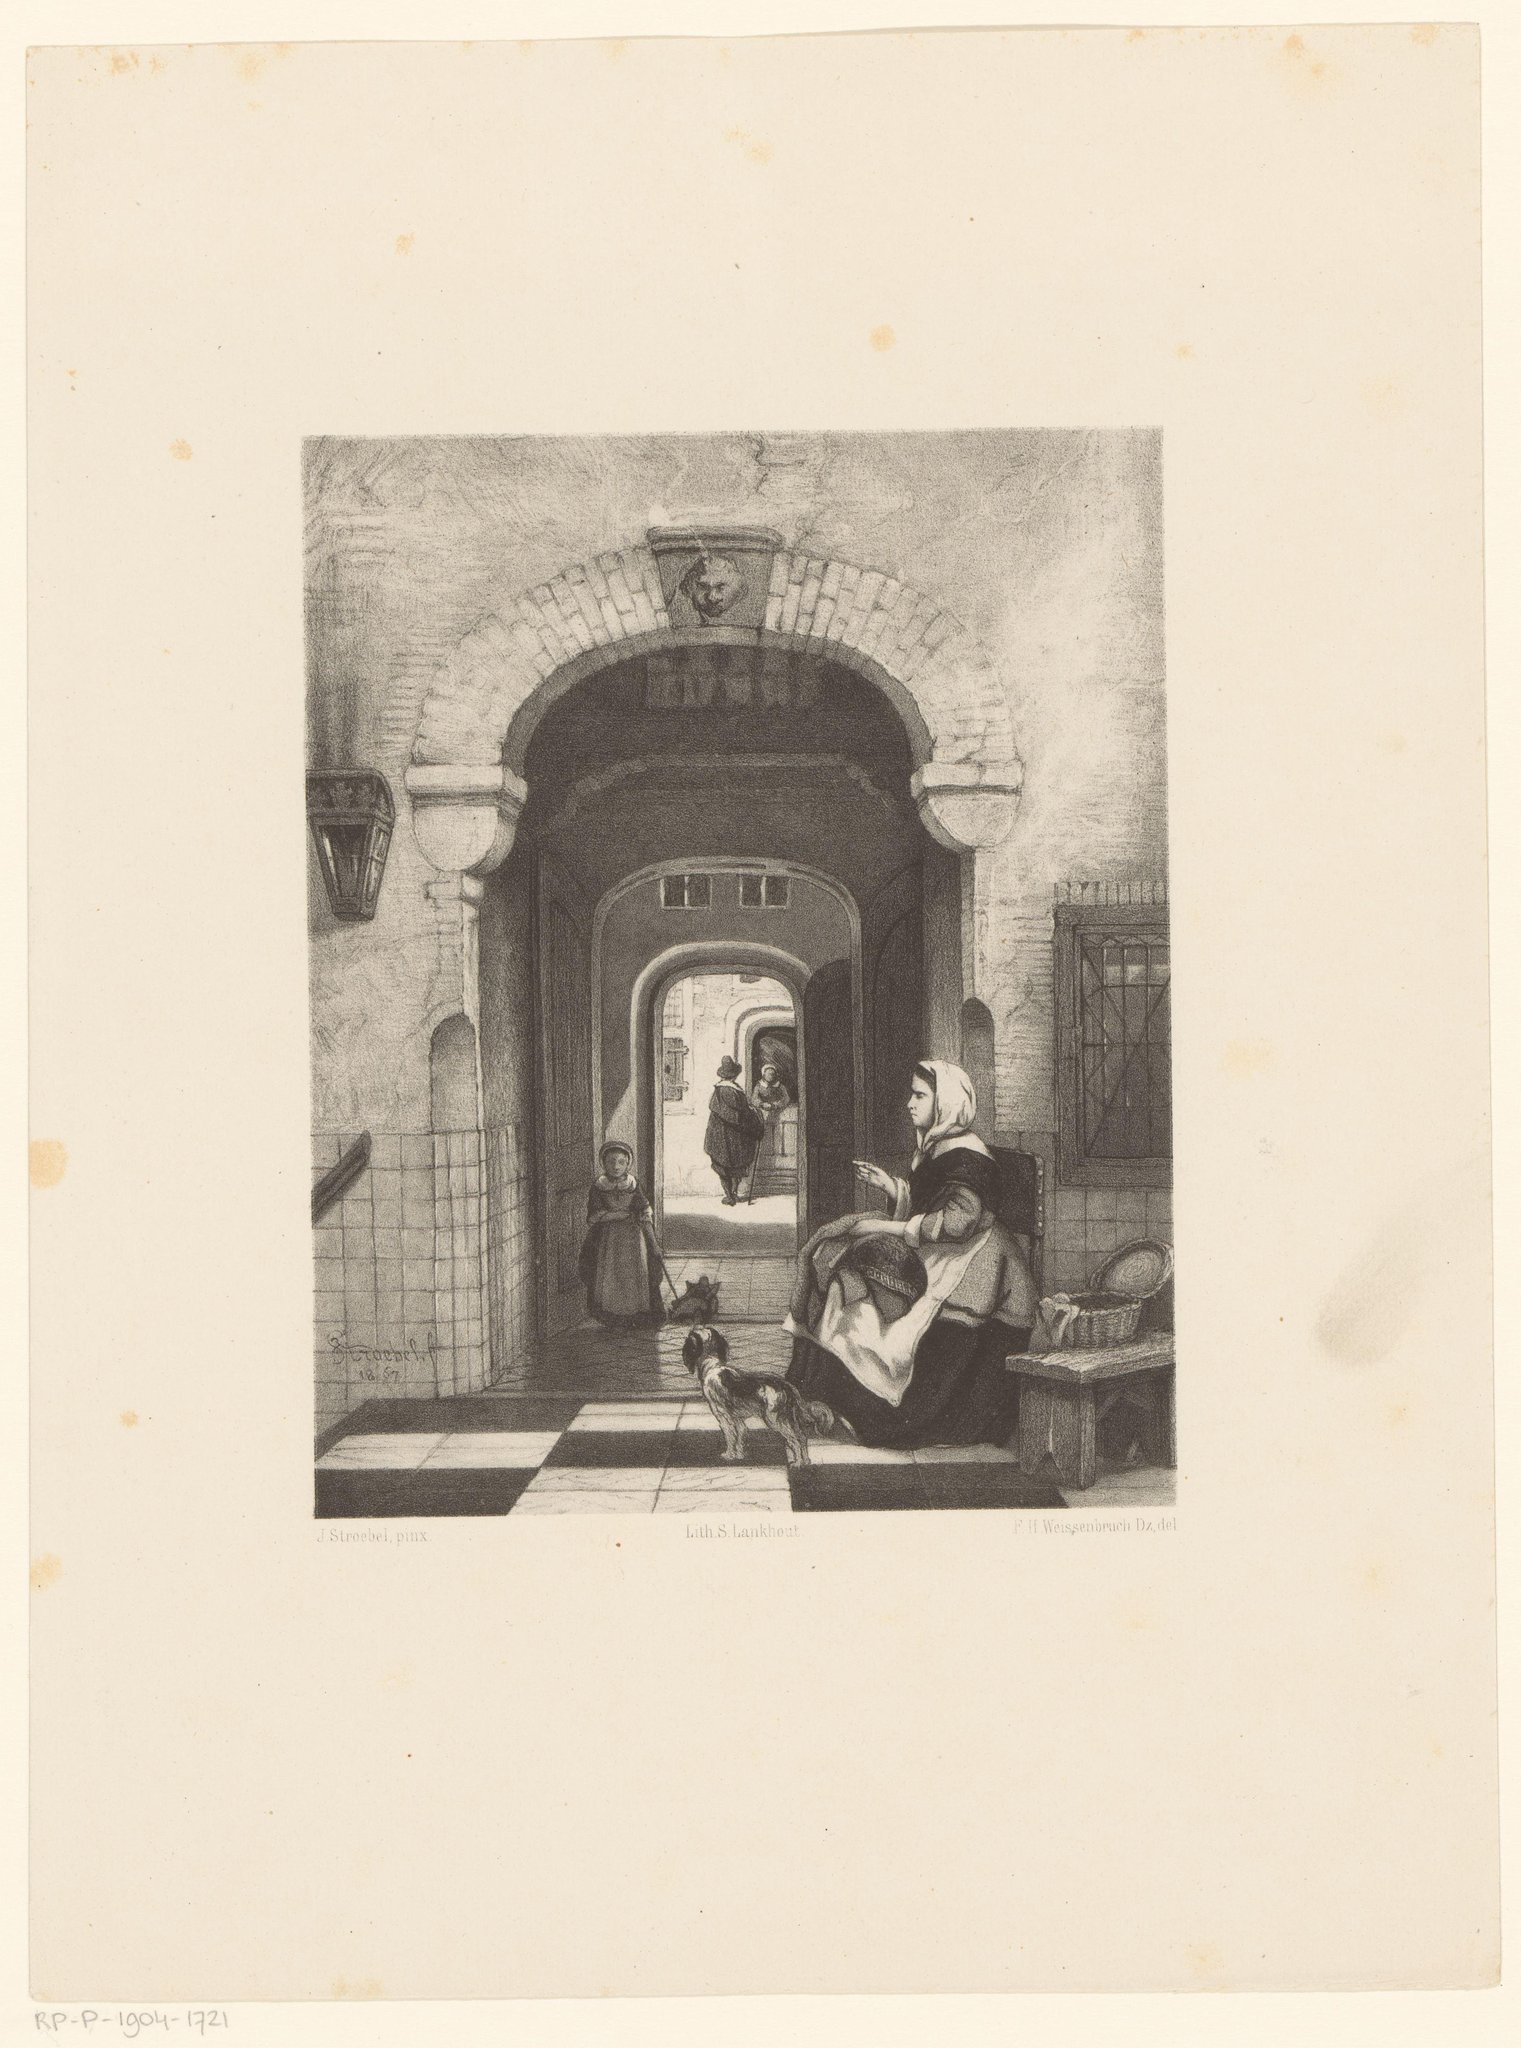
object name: print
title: Vrouw op binnenplaats en kind met pop in gang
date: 1867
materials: paper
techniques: lithograph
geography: the hague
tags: adult woman, vestibule, hall, (playing with) dolls, courtyard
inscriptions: collector's mark: Lugt 2228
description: Een vrouw zit met naaiwerk op haar schoot op een binnenplaats van een huis naast een gang. In de gang staat een meisje met poppenwagen. Door de gang is de straat te zien. Een man aan de overkant van de straat is in gesprek met een vrouw leunend op de deur.